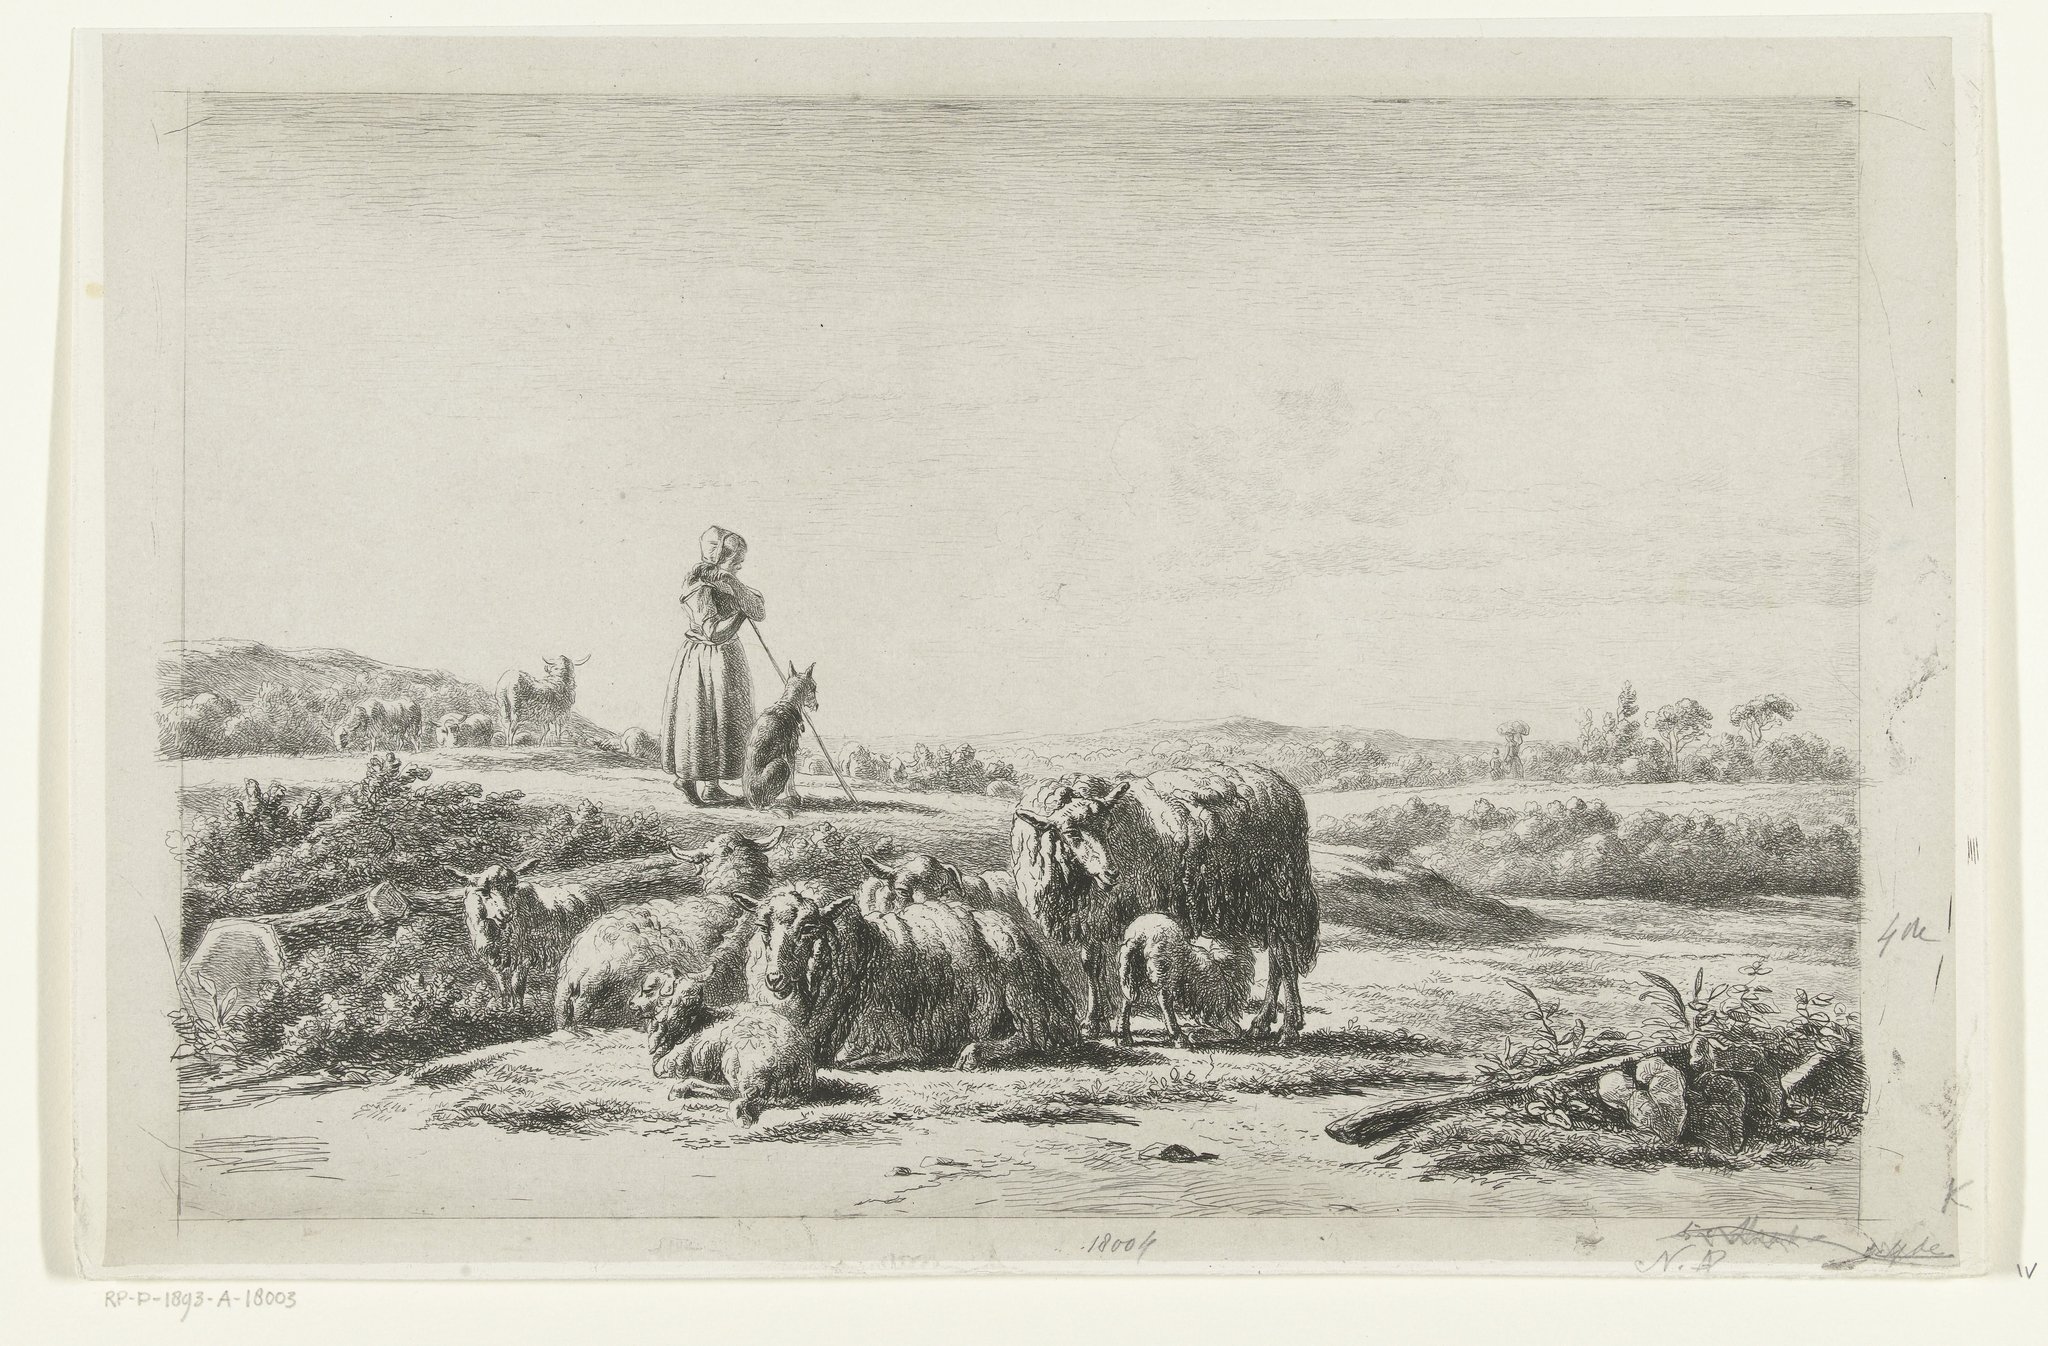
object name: print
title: Landschap met herderin en hond bij kudde schapen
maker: simon van den berg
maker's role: draughtsman, print maker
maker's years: 1812-1891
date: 1822-1893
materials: paper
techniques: drypoint, etching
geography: netherlands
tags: herding, herdsman, herdswoman, shepherd, shepherdess, cowherd, etc., sheep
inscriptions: collector's mark: Lugt 2228